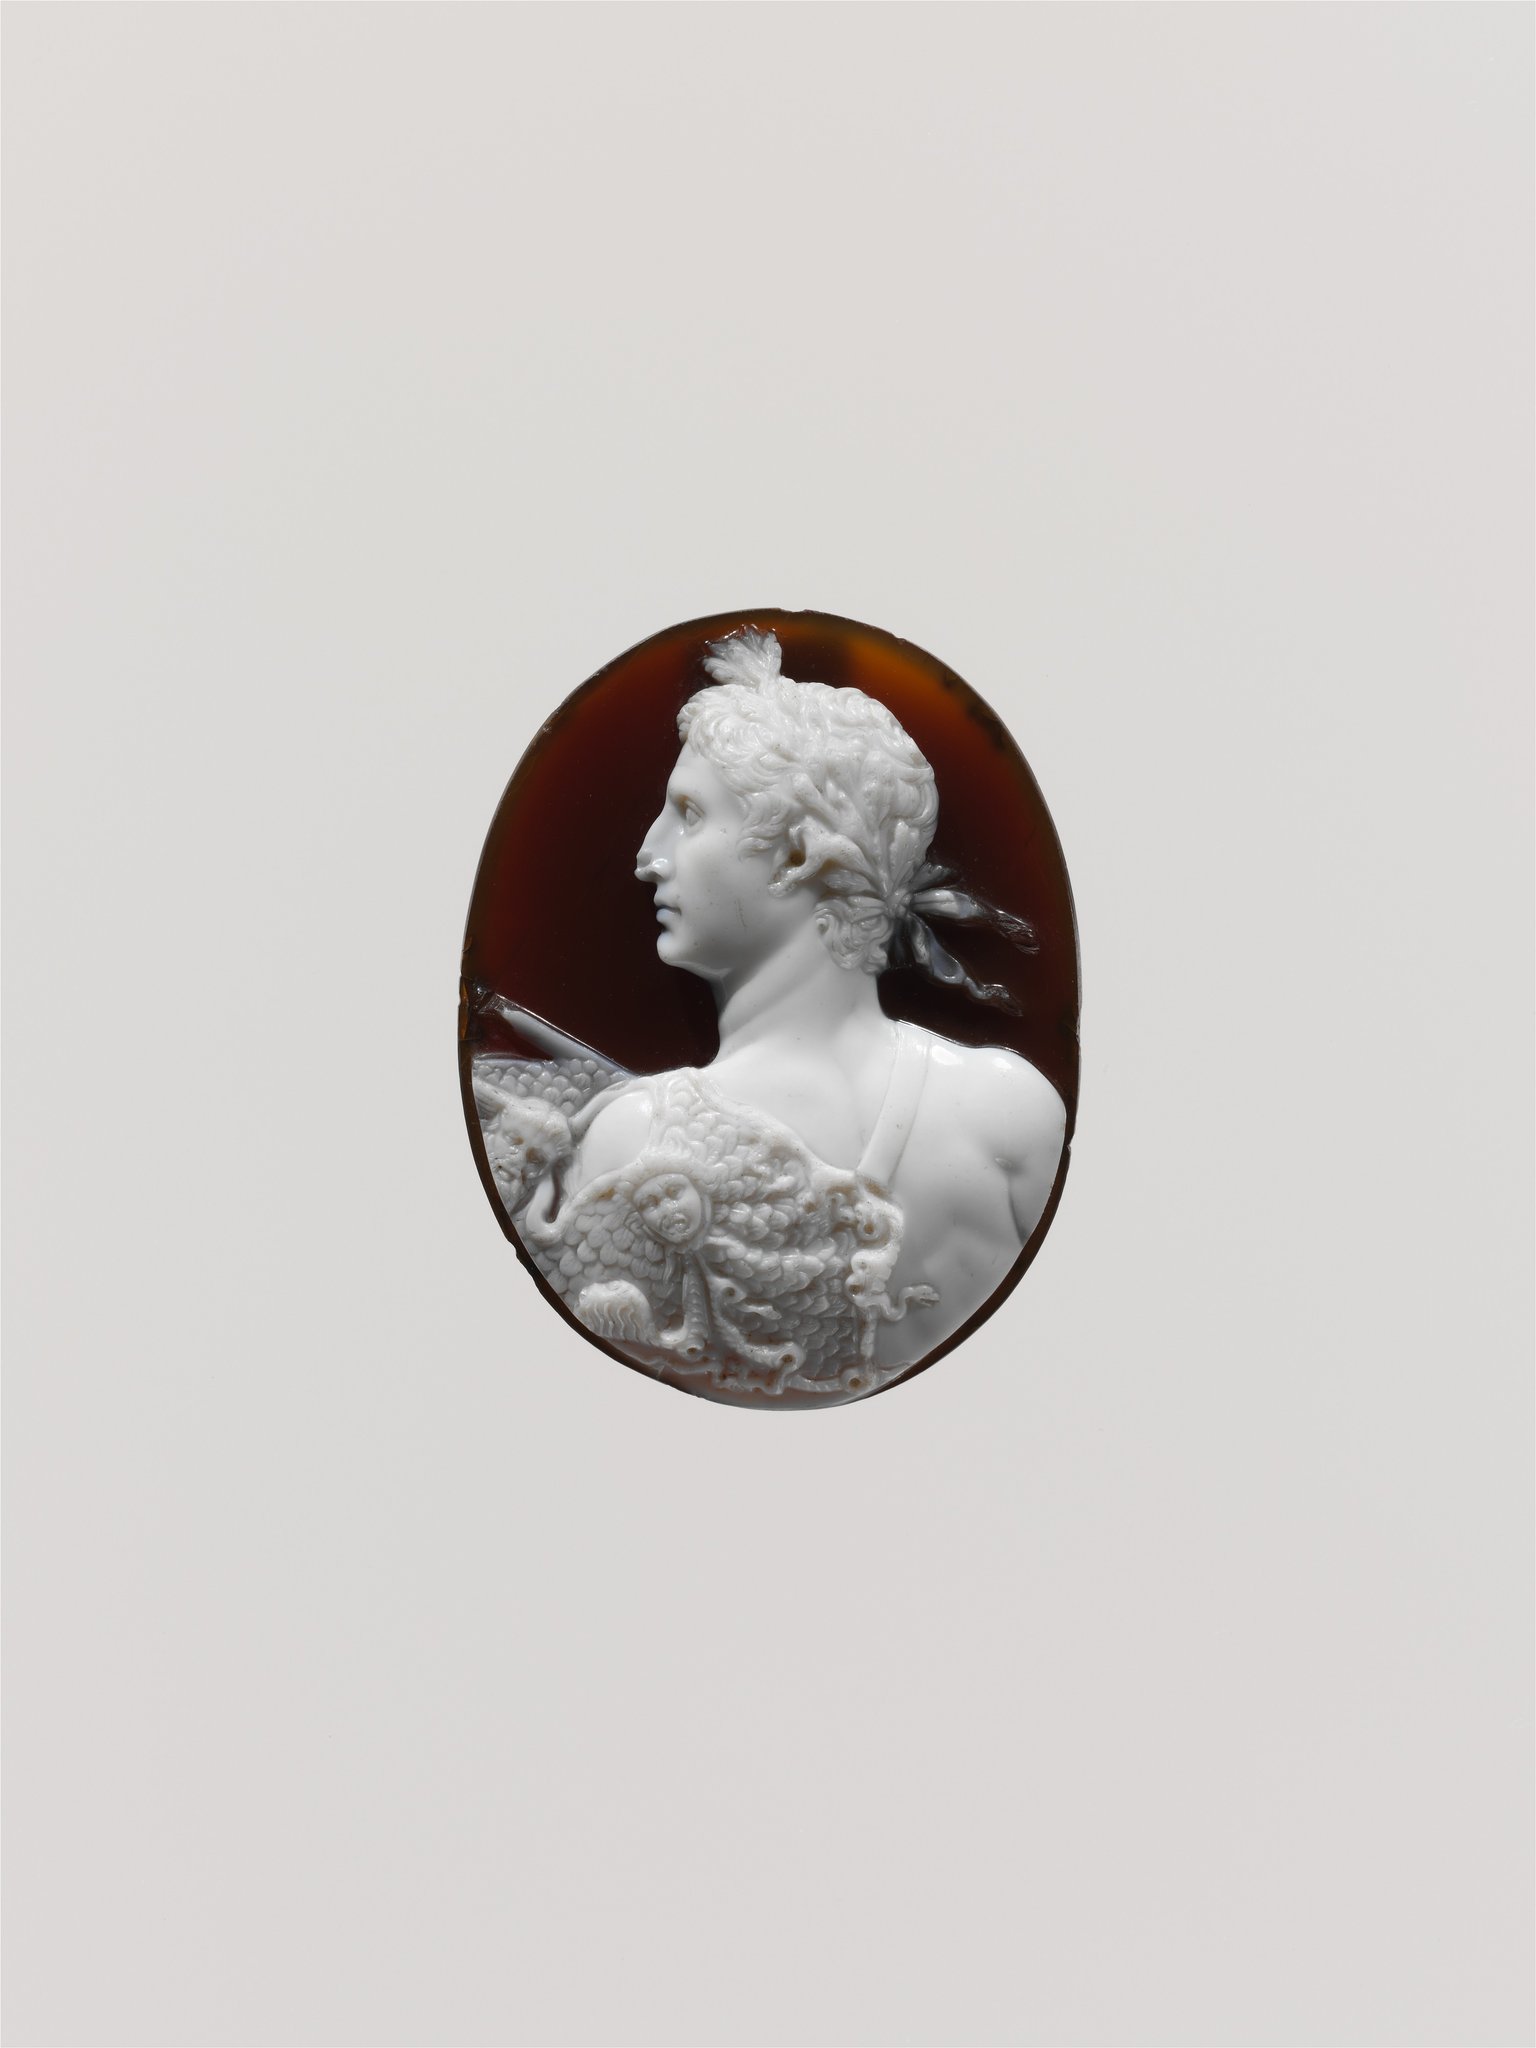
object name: cameo, portrait of augustus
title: Sardonyx cameo portrait of the Emperor Augustus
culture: roman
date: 41-54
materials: gemstone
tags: emperor augustus,men,portraits,profiles